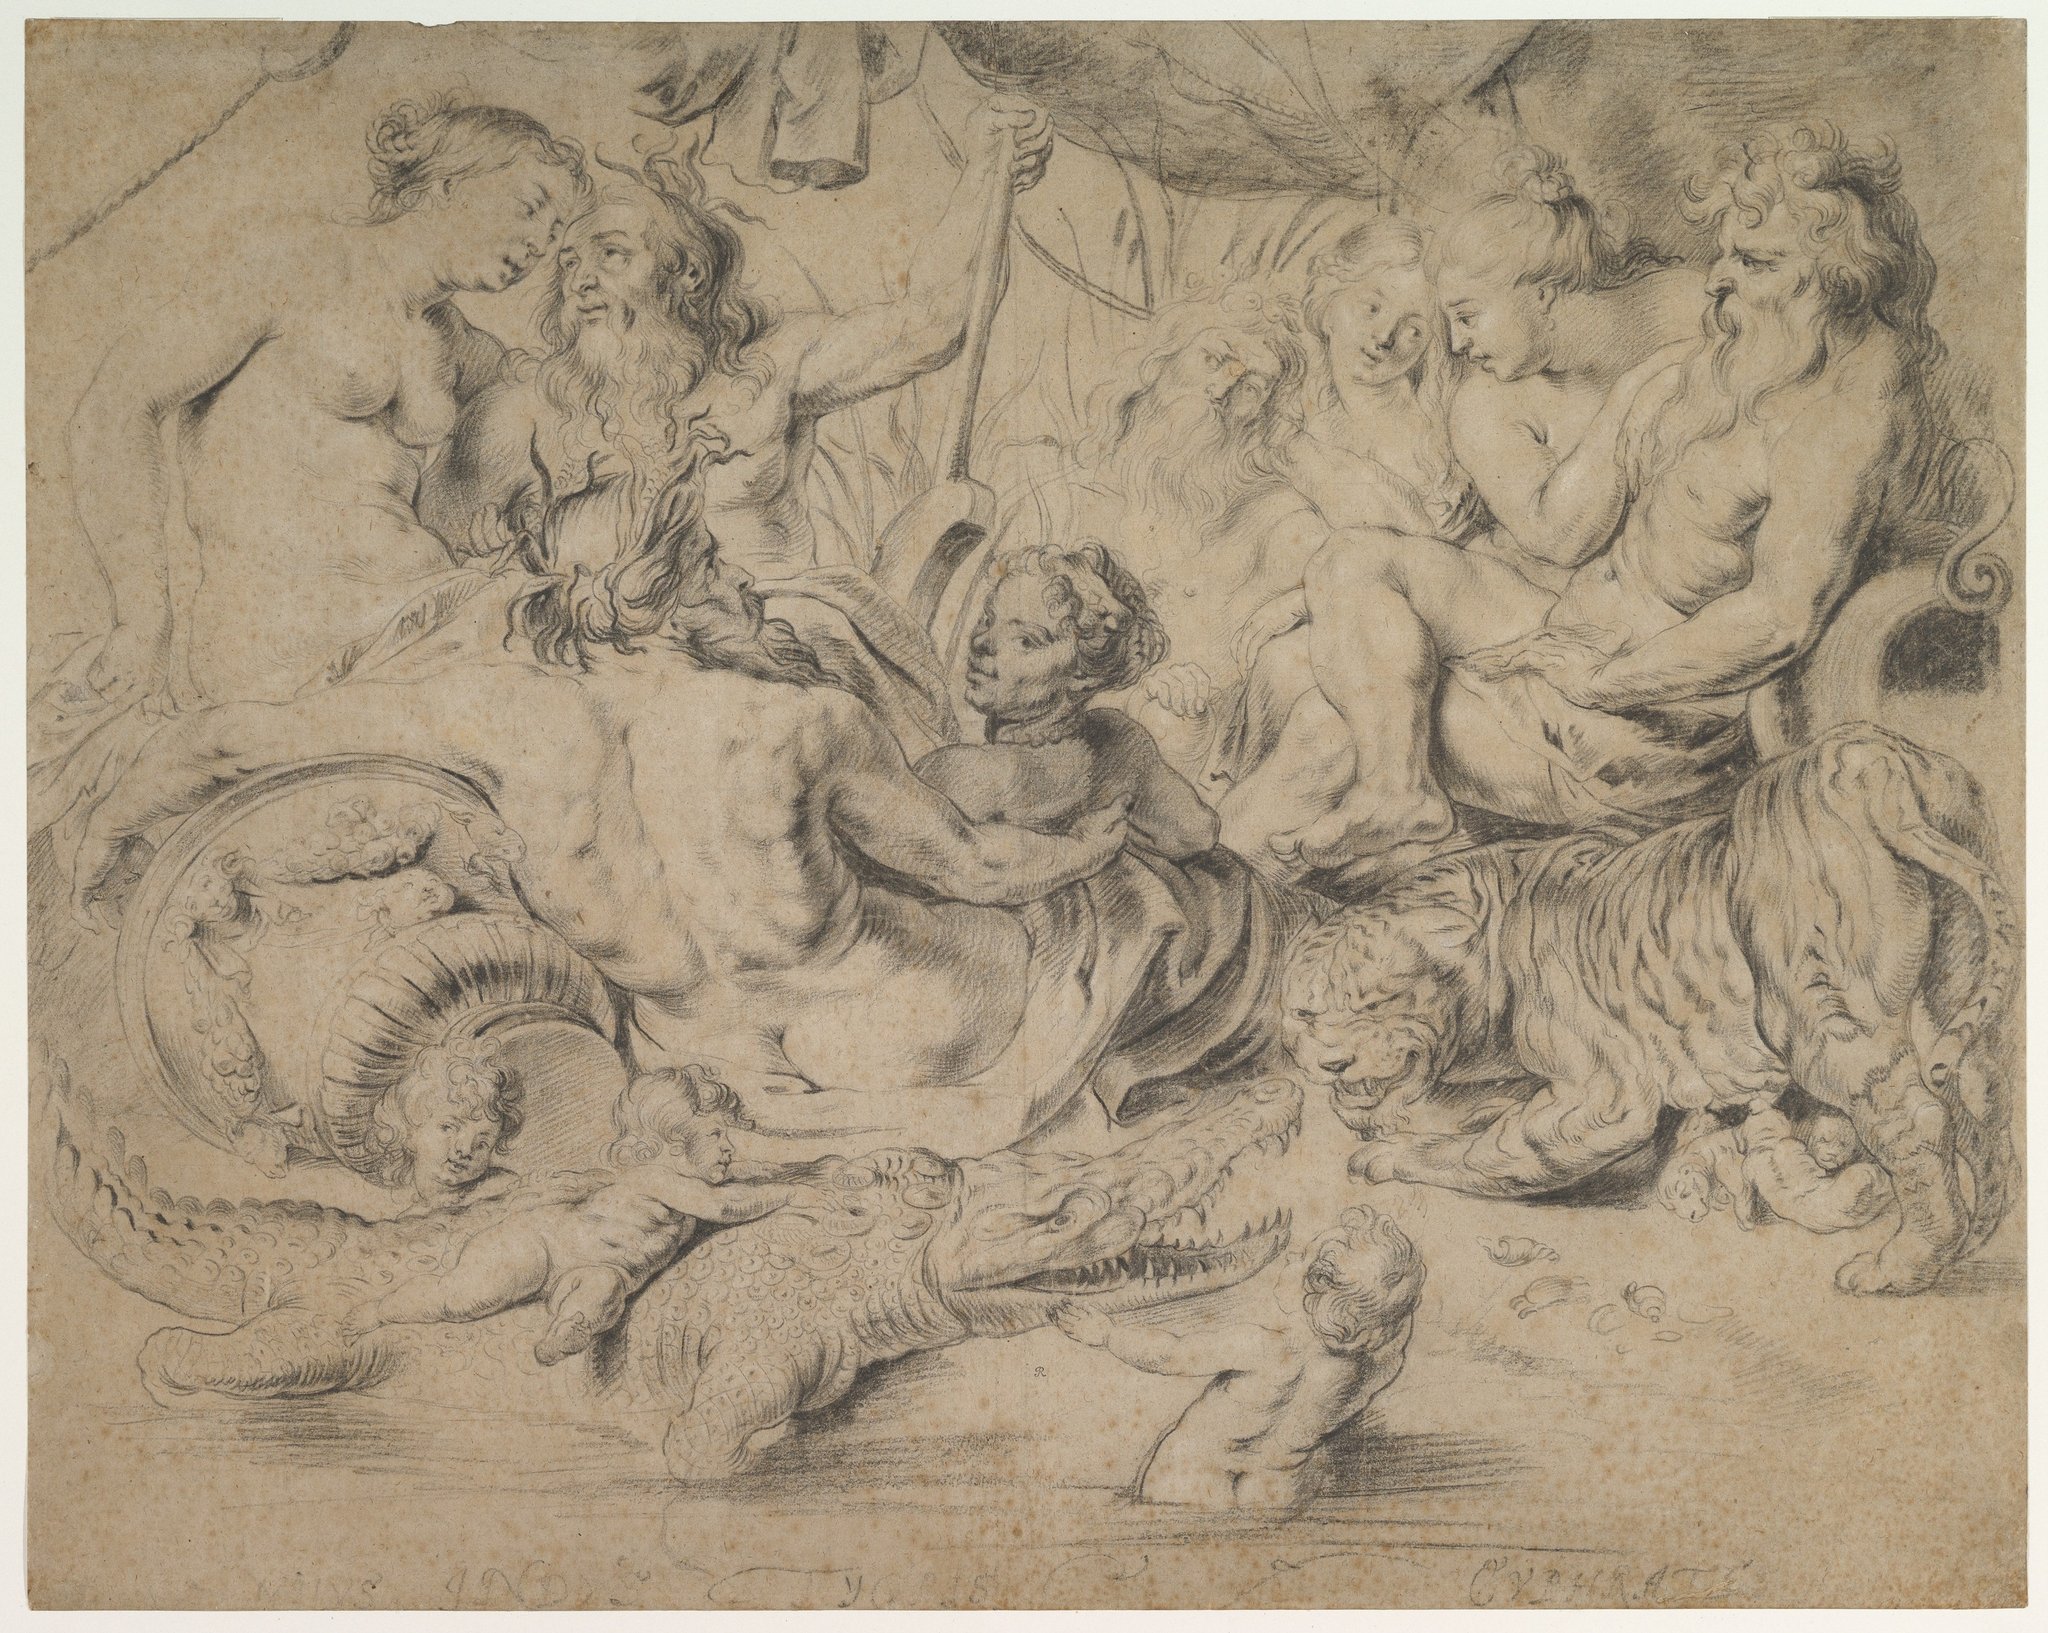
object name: drawing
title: Personifications of the Nile, Indus, Tigris and Euphrates rivers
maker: anonymous, flemish, 17th century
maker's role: artist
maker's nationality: flemish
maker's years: 1600-1700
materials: chalk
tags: male nudes,female nudes,putti,crocodiles,tigers